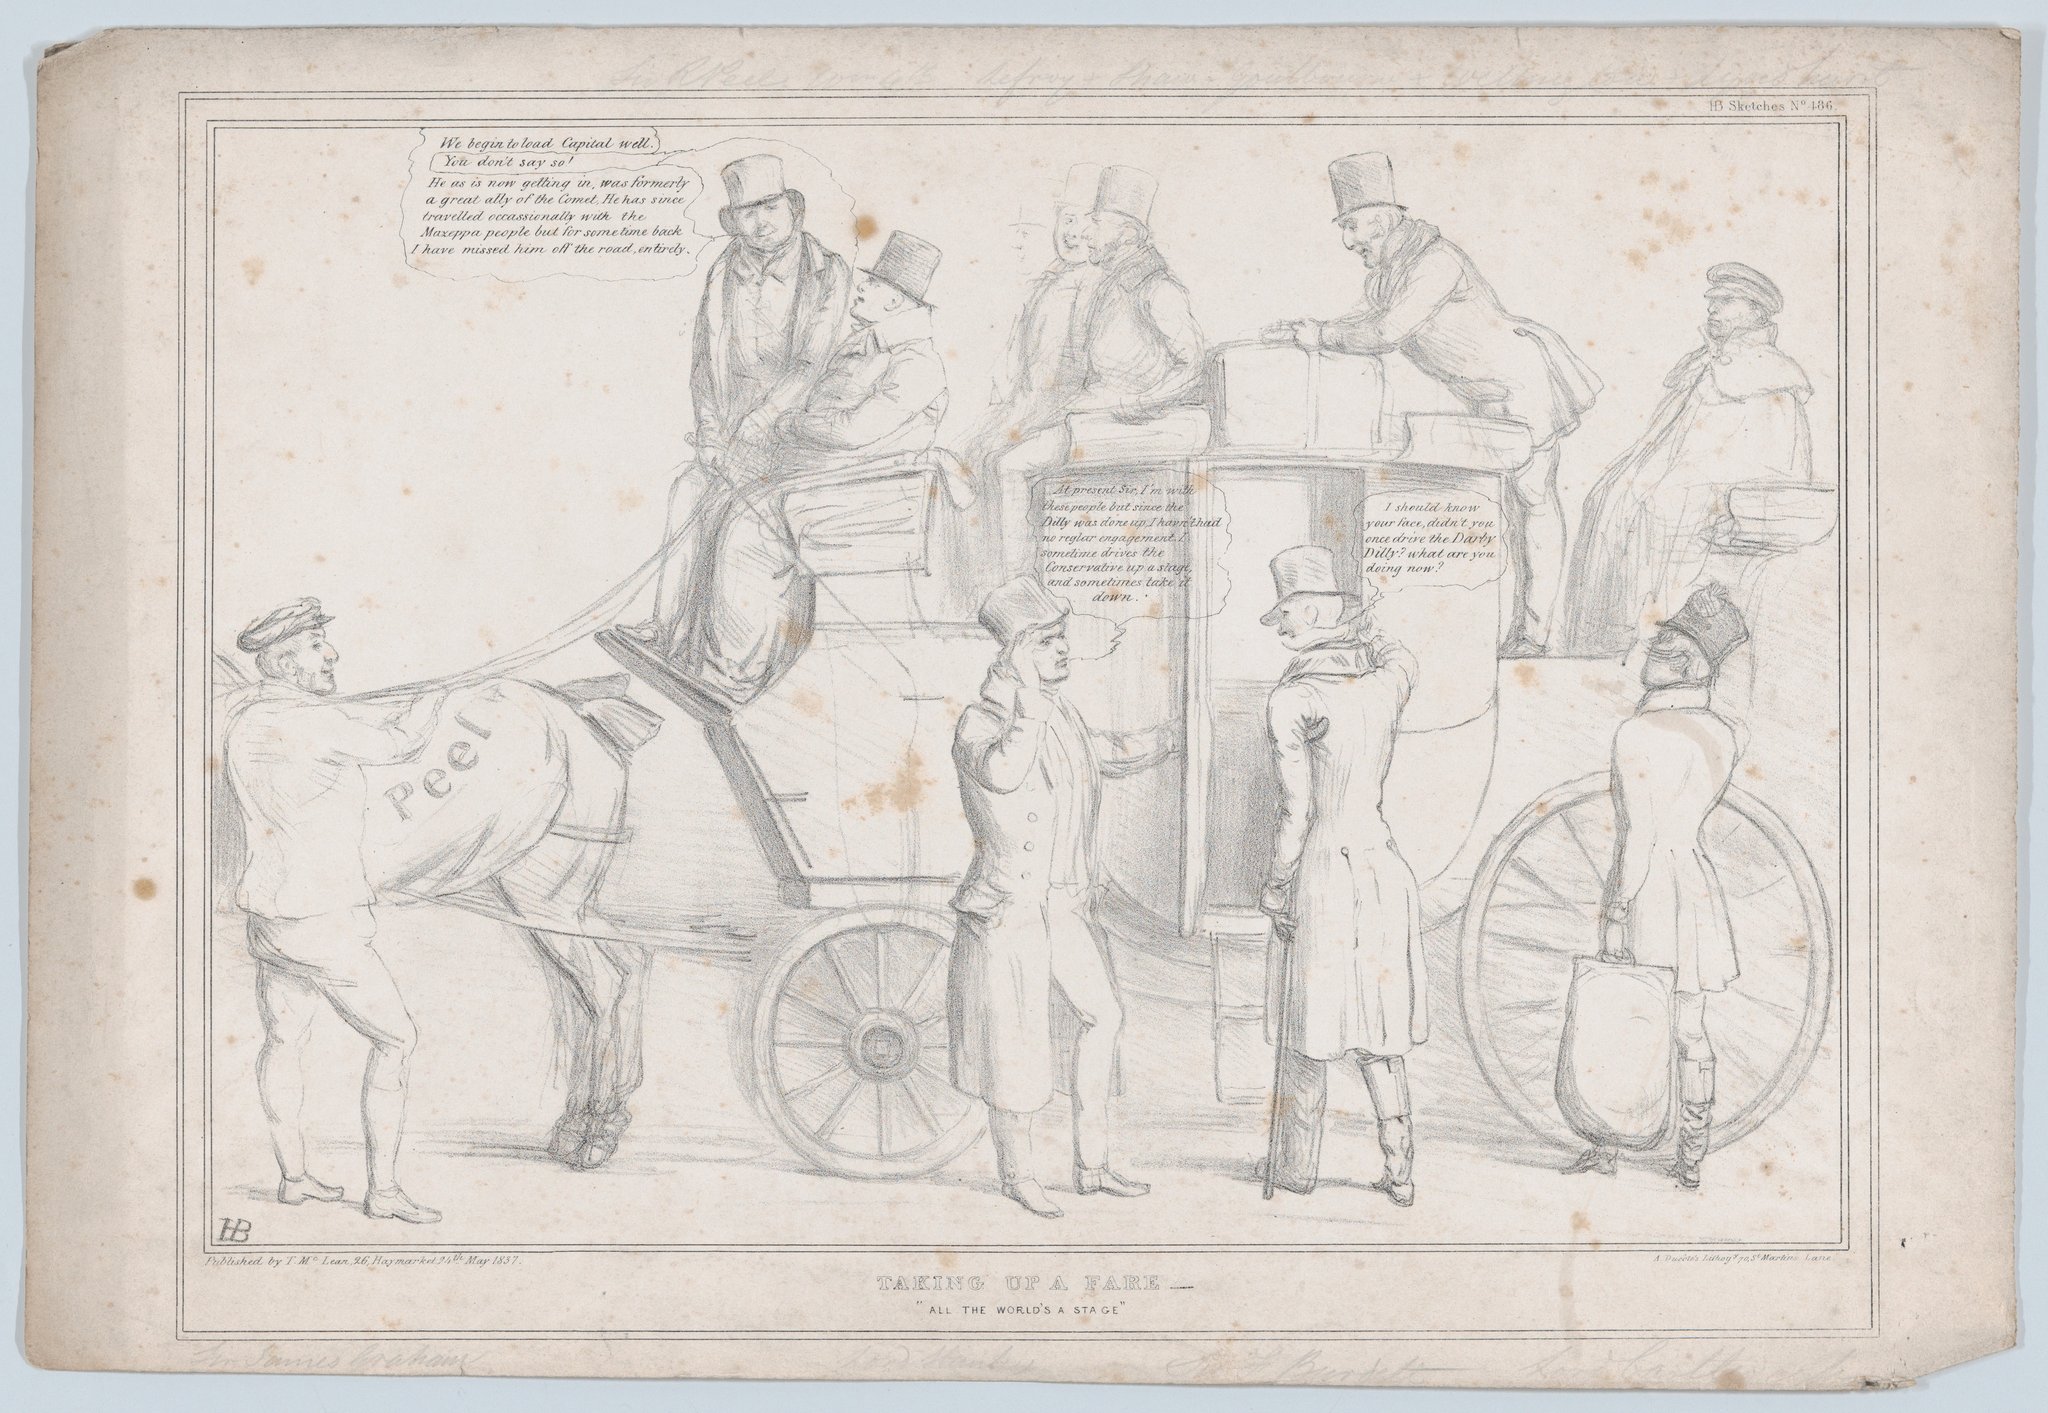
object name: print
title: Taking Up a Fare – "All the World's A Stage"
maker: john doyle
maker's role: artist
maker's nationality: irish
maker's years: 1797-1868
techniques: lithograph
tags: men,carriages